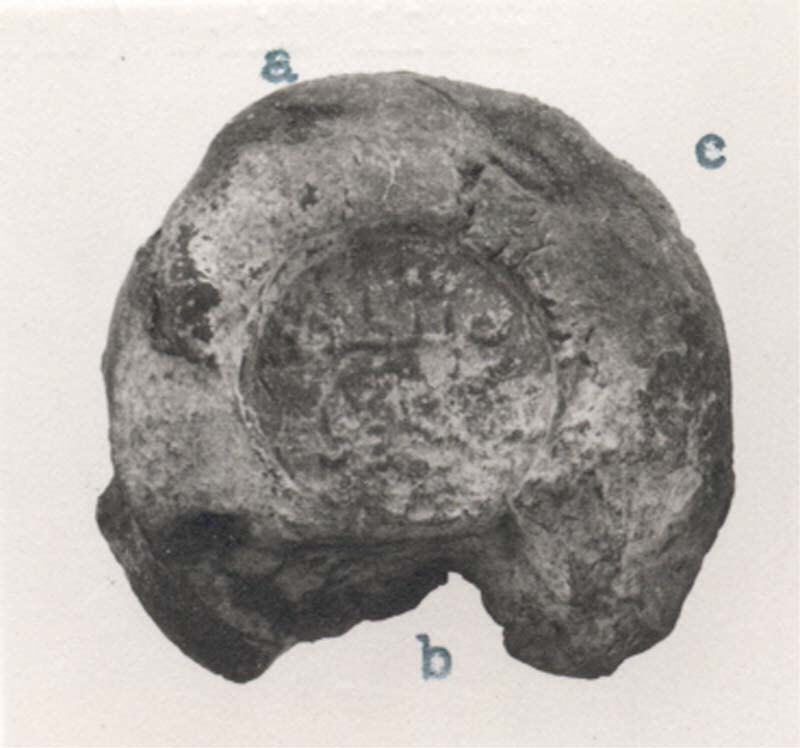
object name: sealing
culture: sasanian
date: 601-700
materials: clay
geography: iran